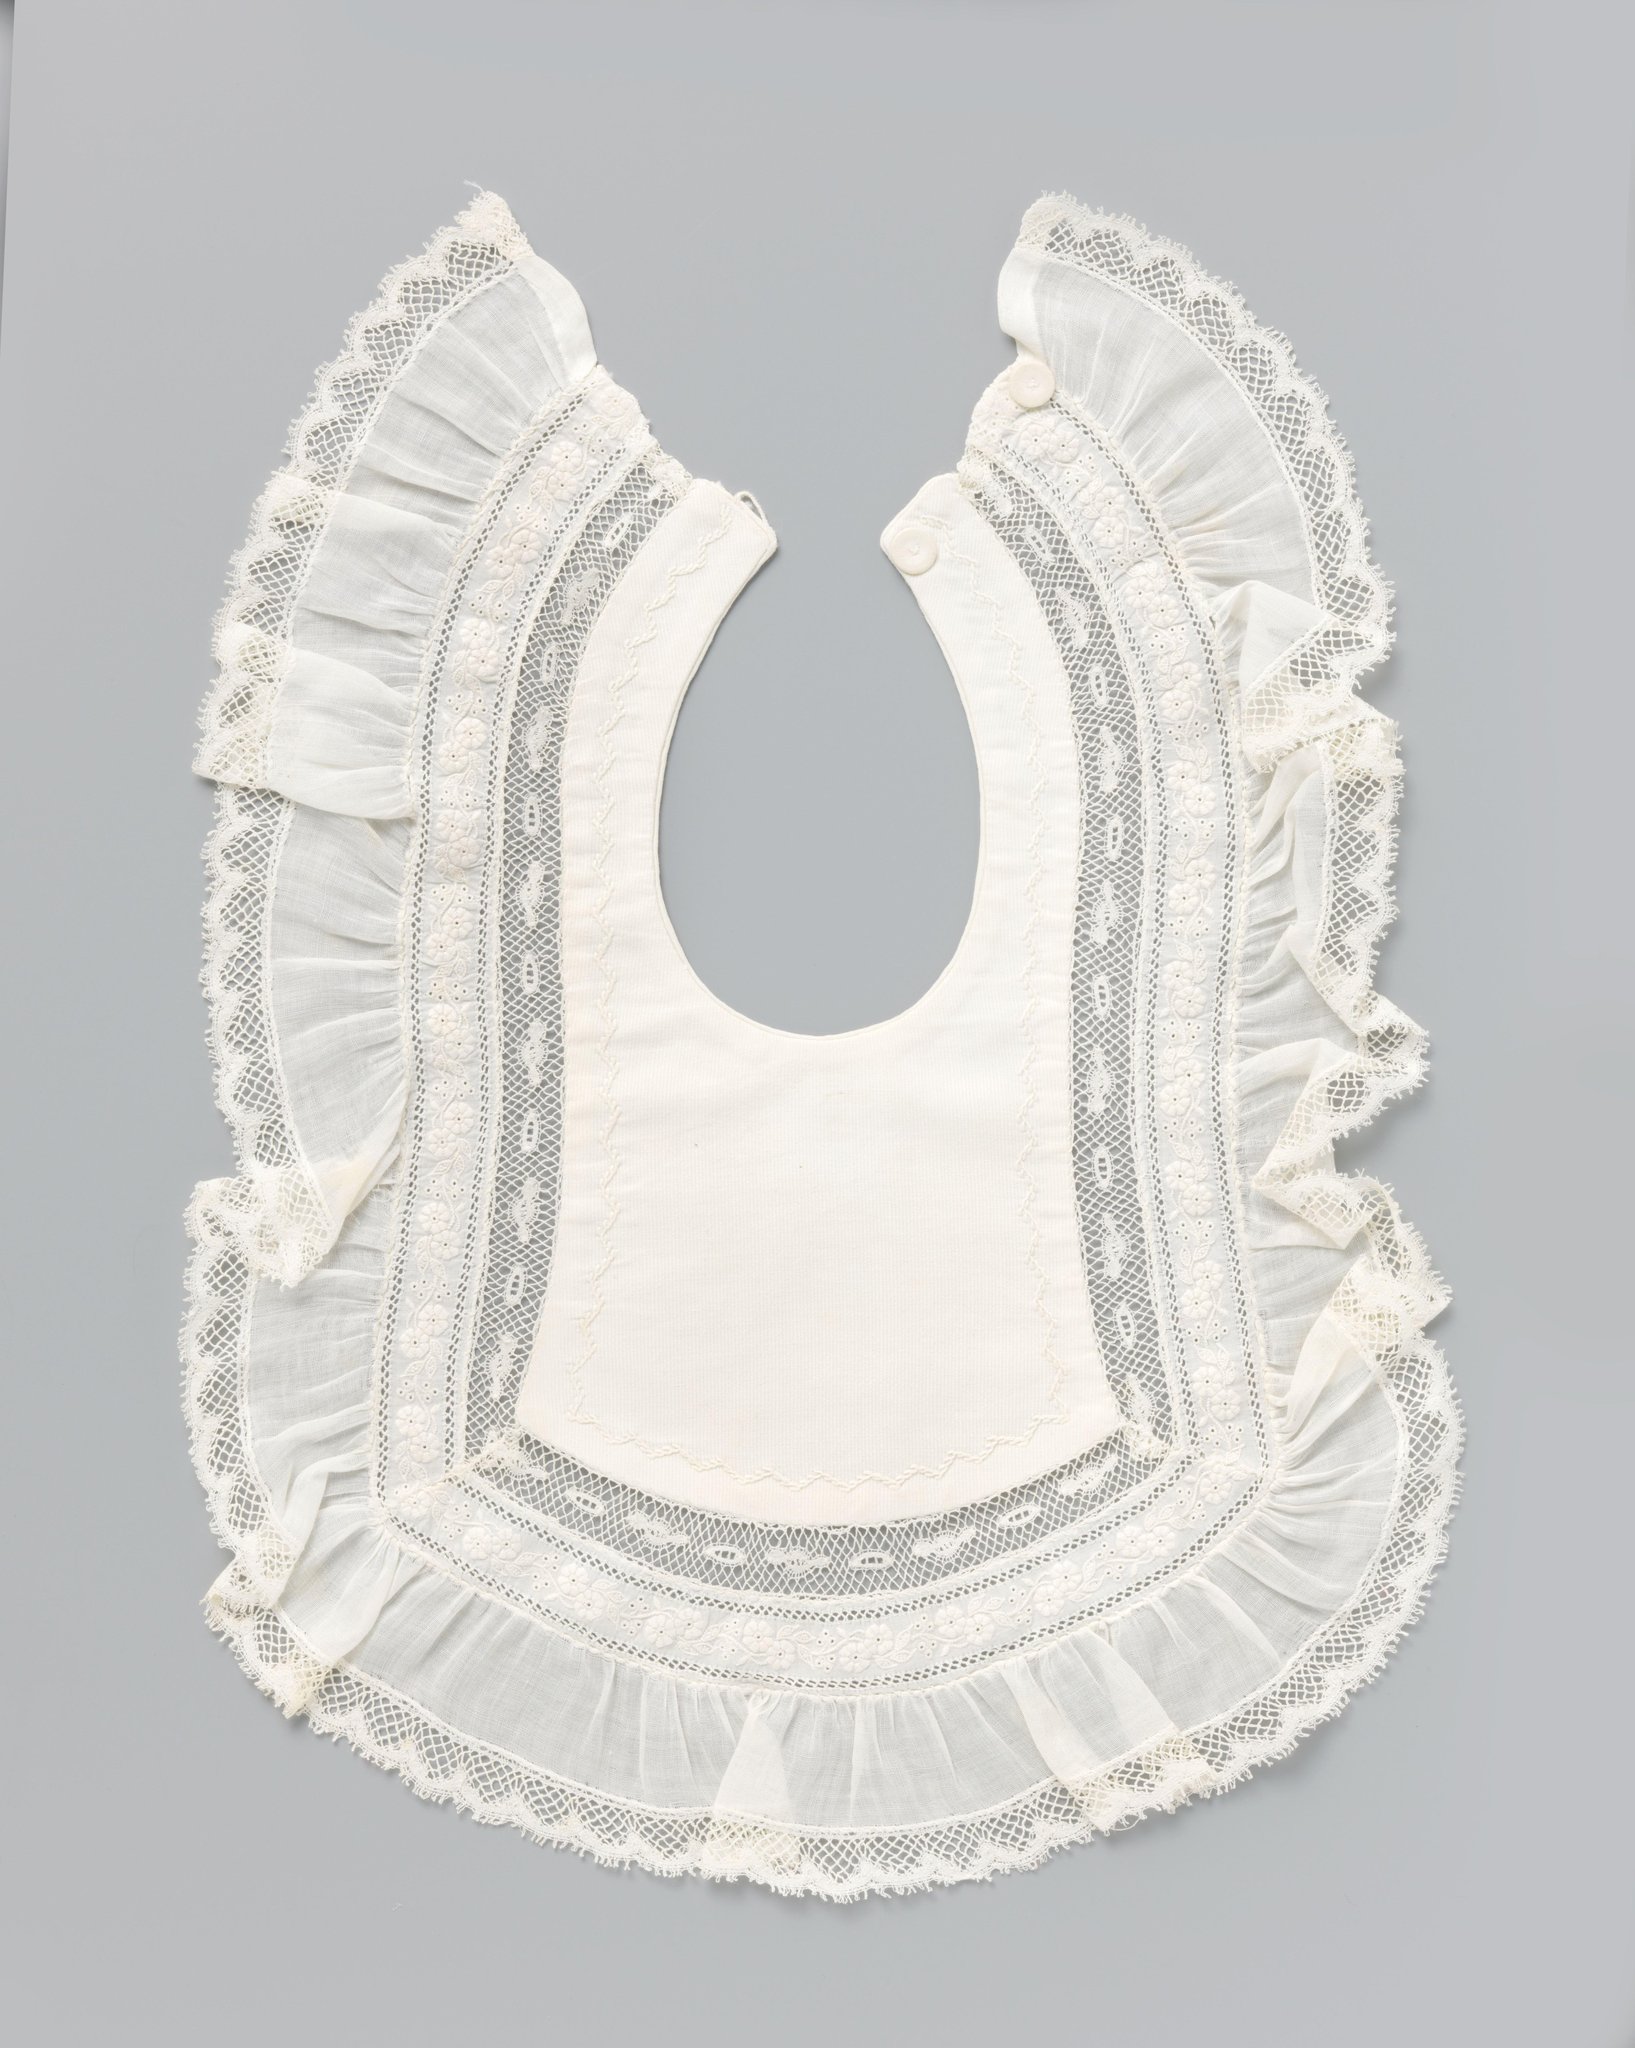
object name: bib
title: Slab met verticaal ingeweven streep, waaromheen een witte geborduurde zigzagrand en versierd met Valenciennes-kant, borduurwerk en ruche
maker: Anonymous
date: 1880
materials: textile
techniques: lace, embroidered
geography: netherlands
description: Een bavetje (slab) van piqué met tussenzetsels van Valenciennes-kant en machinaal borduurwerk, afgezet met een batist strook met Valenciennes-kant.